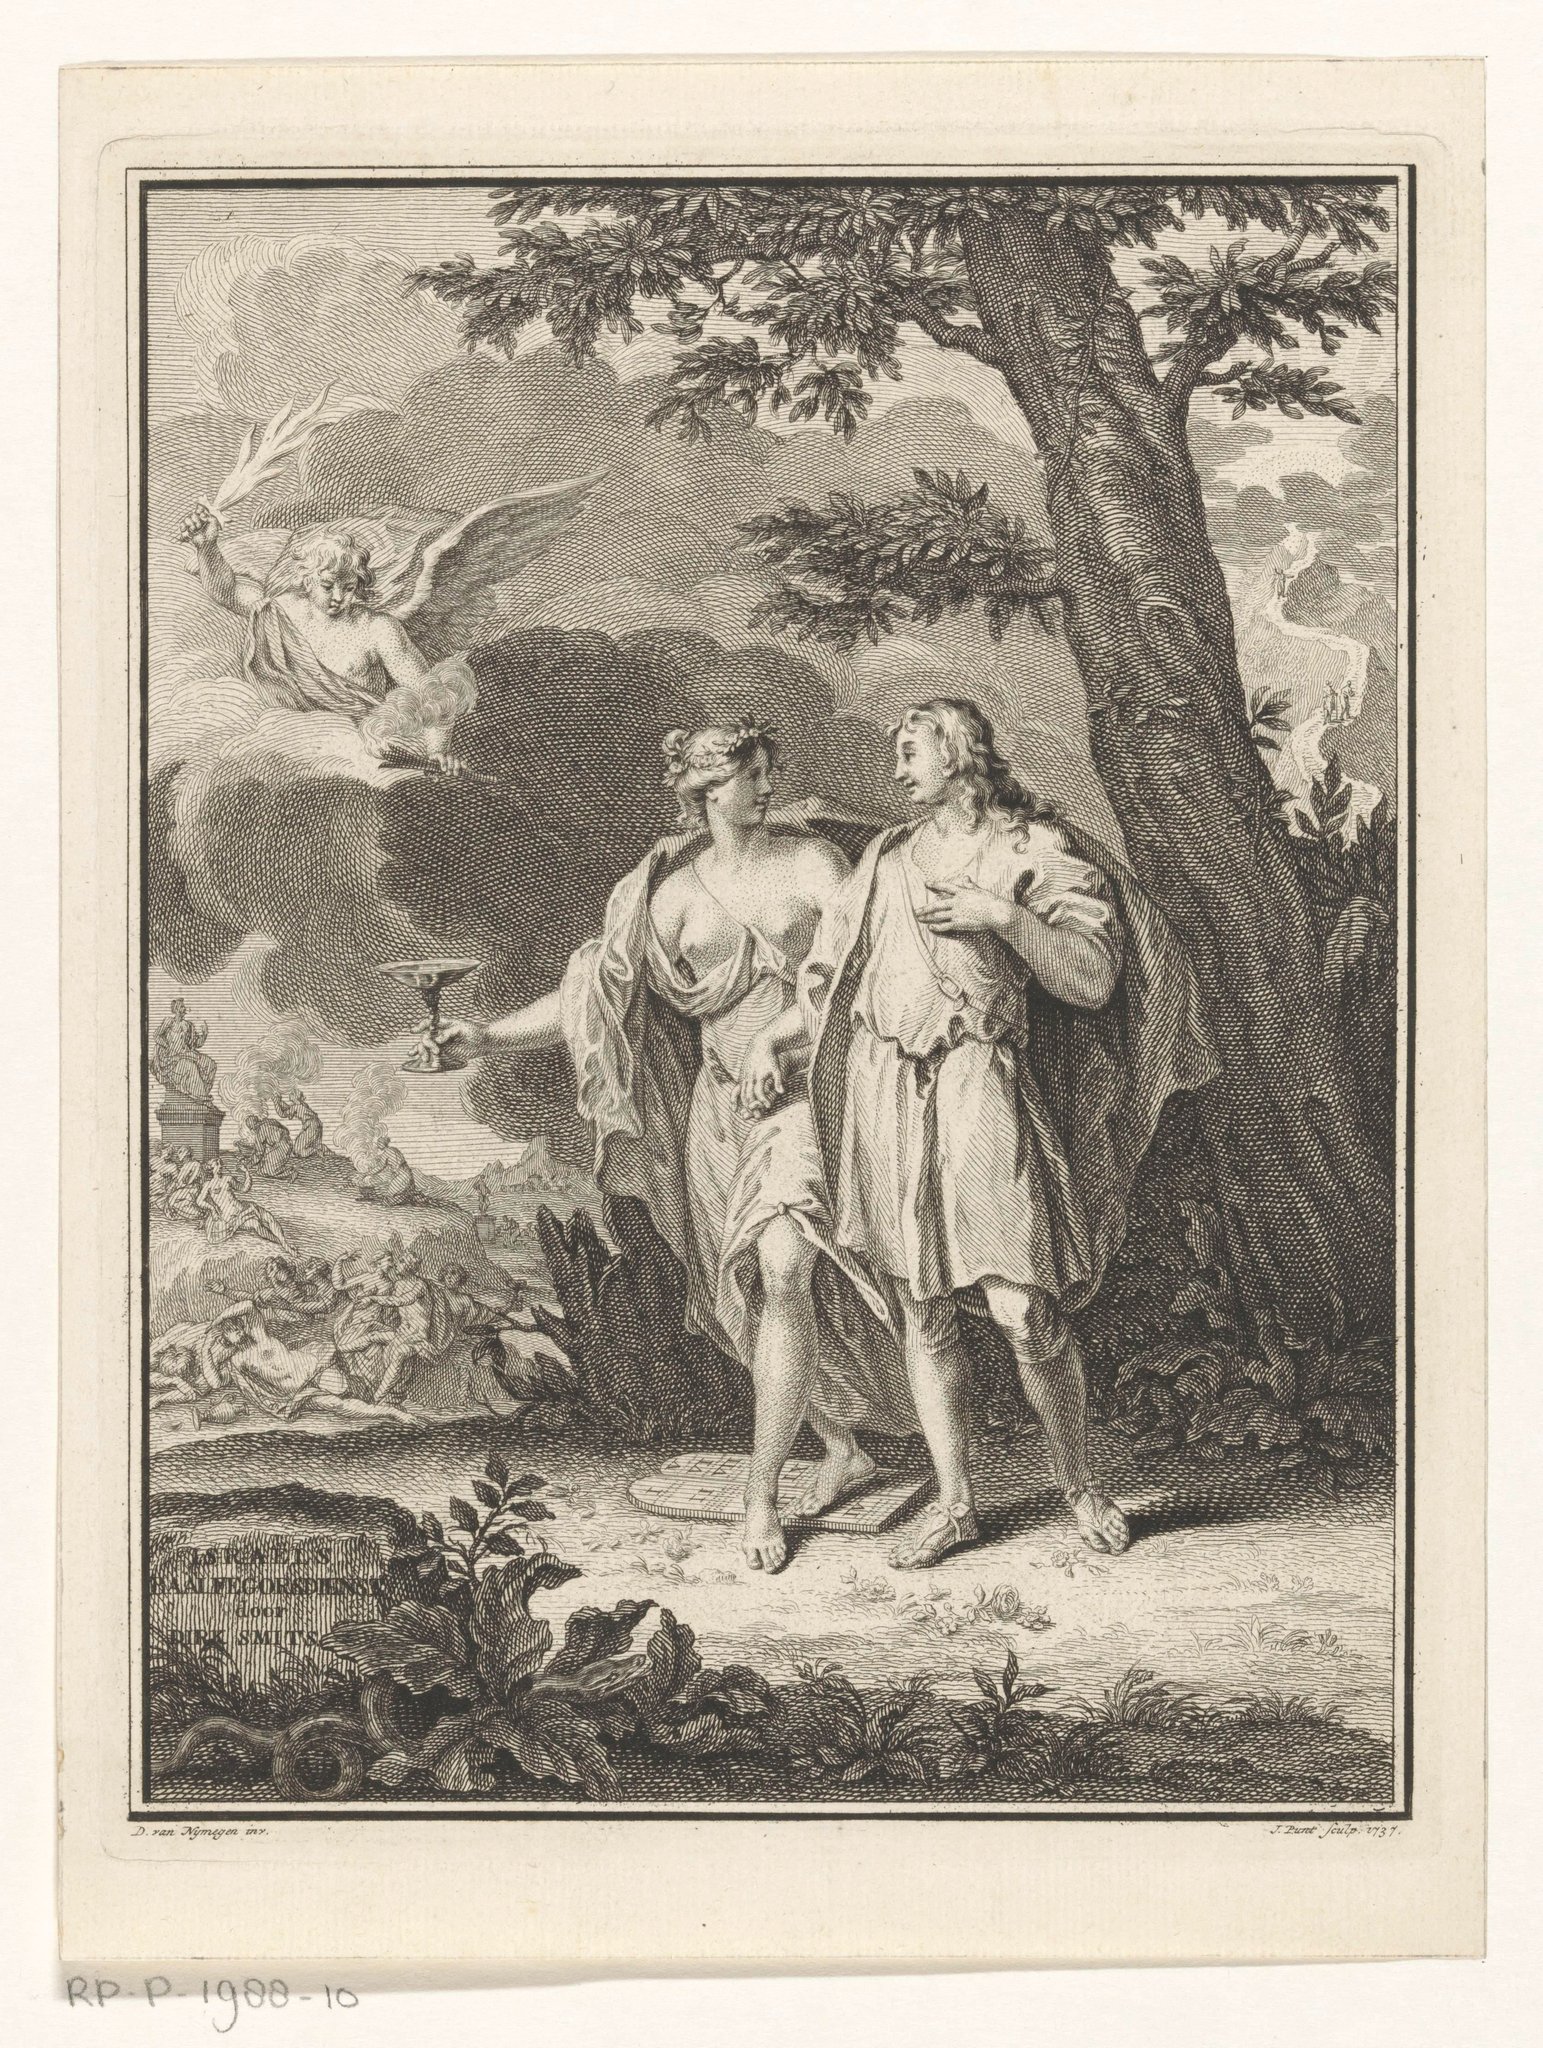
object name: titelblad, titelpagina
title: Titelpagina voor: Dirk Smits, Israëls Baälfegorsdienst, of Gestrafte wellust, 1737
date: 1737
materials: paper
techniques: engraving, etching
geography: rotterdam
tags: snakes, the moabite women lead the israelites into the worship of baal-peor, lust, luxury, 'luxuria'; 'lussuria' (ripa) ~ personification of one of the deadly sins, the new tables of the law (exodus 34)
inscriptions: collector's mark: Lugt 2760, collector's mark: Lugt 2228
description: Wellust voert een jonge man aan de hand mee en verleidt hem om van het goede pad af te wijken. Ze stapt met haar voet op de tafelen der wet. In de lucht kijkt de Wraak toe, met een zwaard en toorts in de handen. Links op de voorgrond een slang en op een steen de titel. Op de achtergrond de verering van Baäl en wellustige figuren.